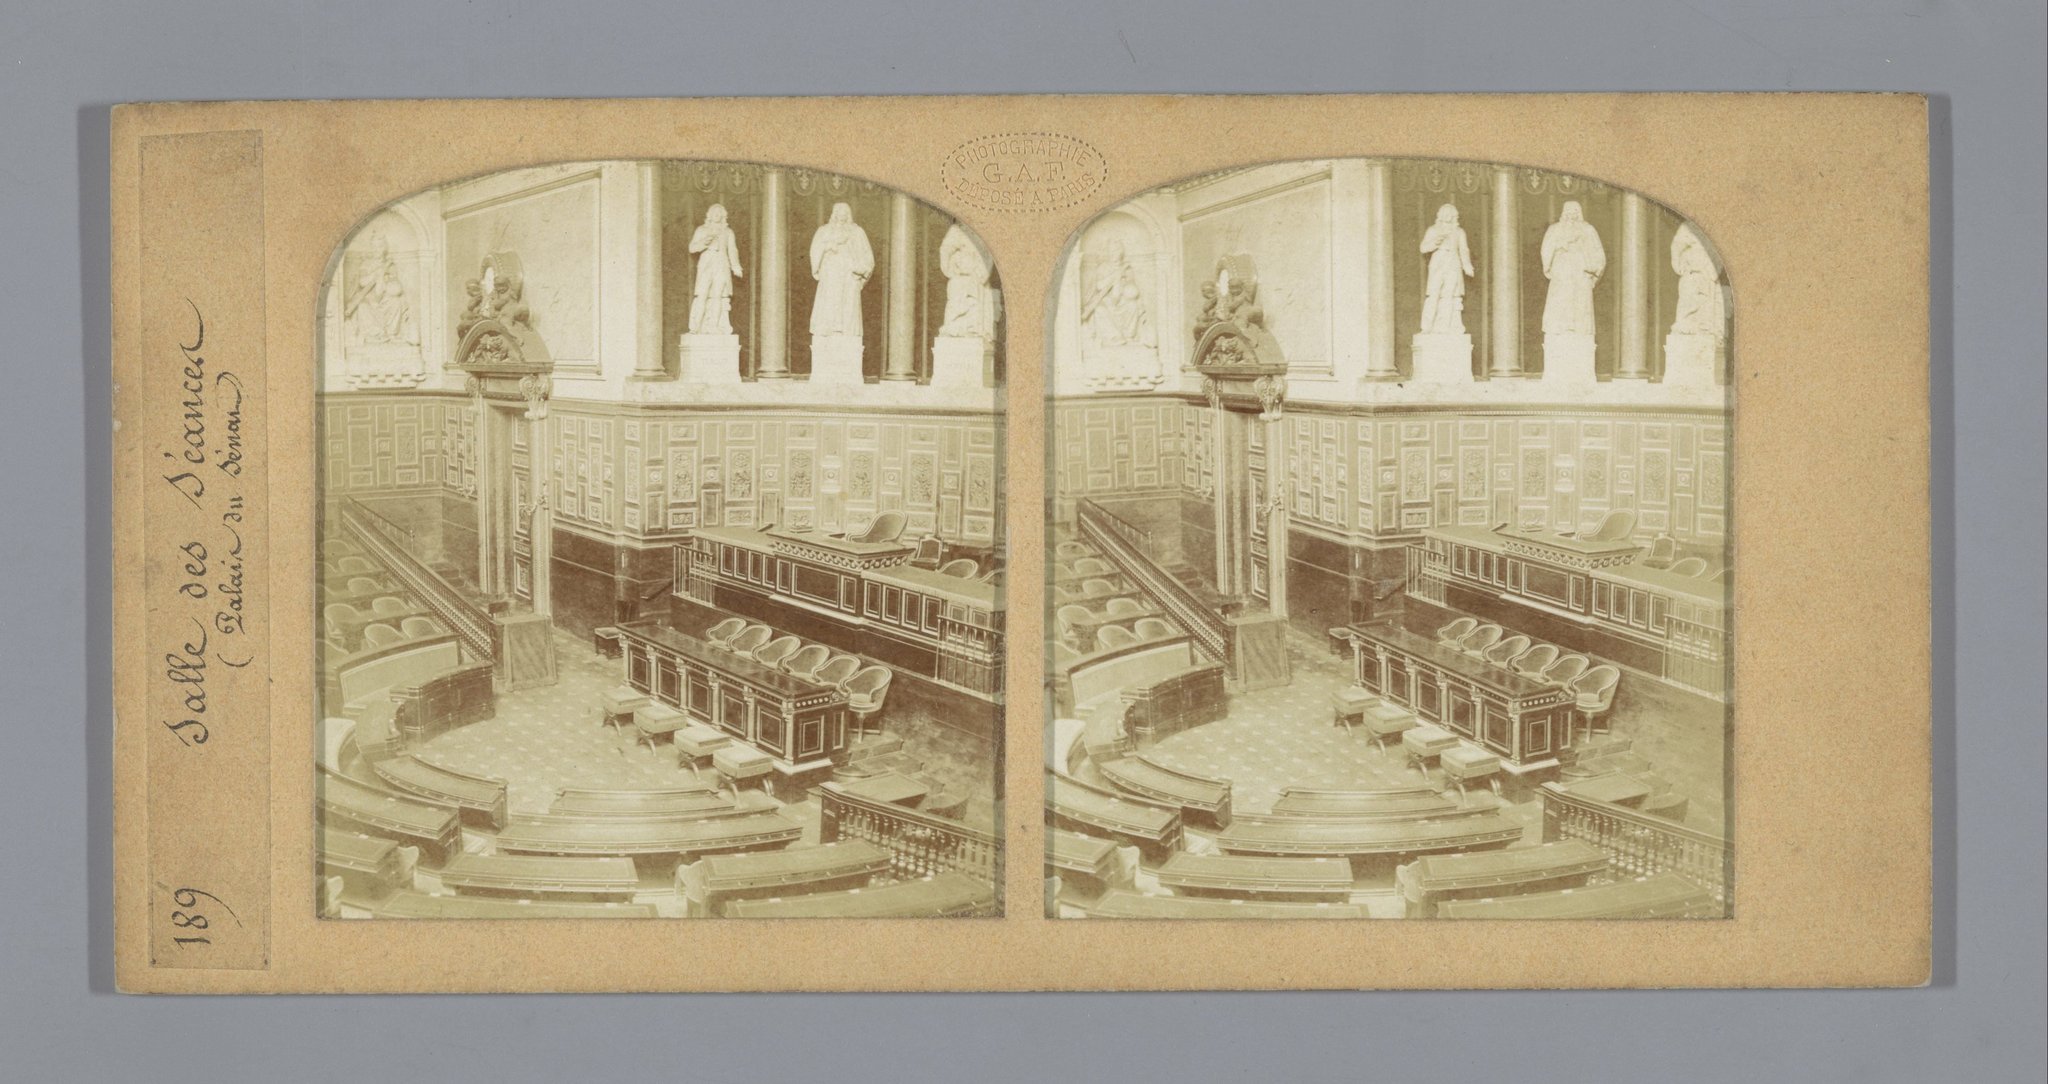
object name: tissue stereograph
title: Plenaire zaal van de Franse Senaat, Parijs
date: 1859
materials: cardboard, paper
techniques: albumen print, hand coloring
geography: cologne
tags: upper house, senate, paris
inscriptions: number: ‘189’, inscription: ‘Q’, retailer's mark: ‘Kunsthandlung/ Joh. Heinrigs/ in/ Cöln/ Hochstrasse 152./ Liefert alle im In. und Auslande/ erschienenen Kunstblätter.’, inscription: ‘Déposé a Paris’